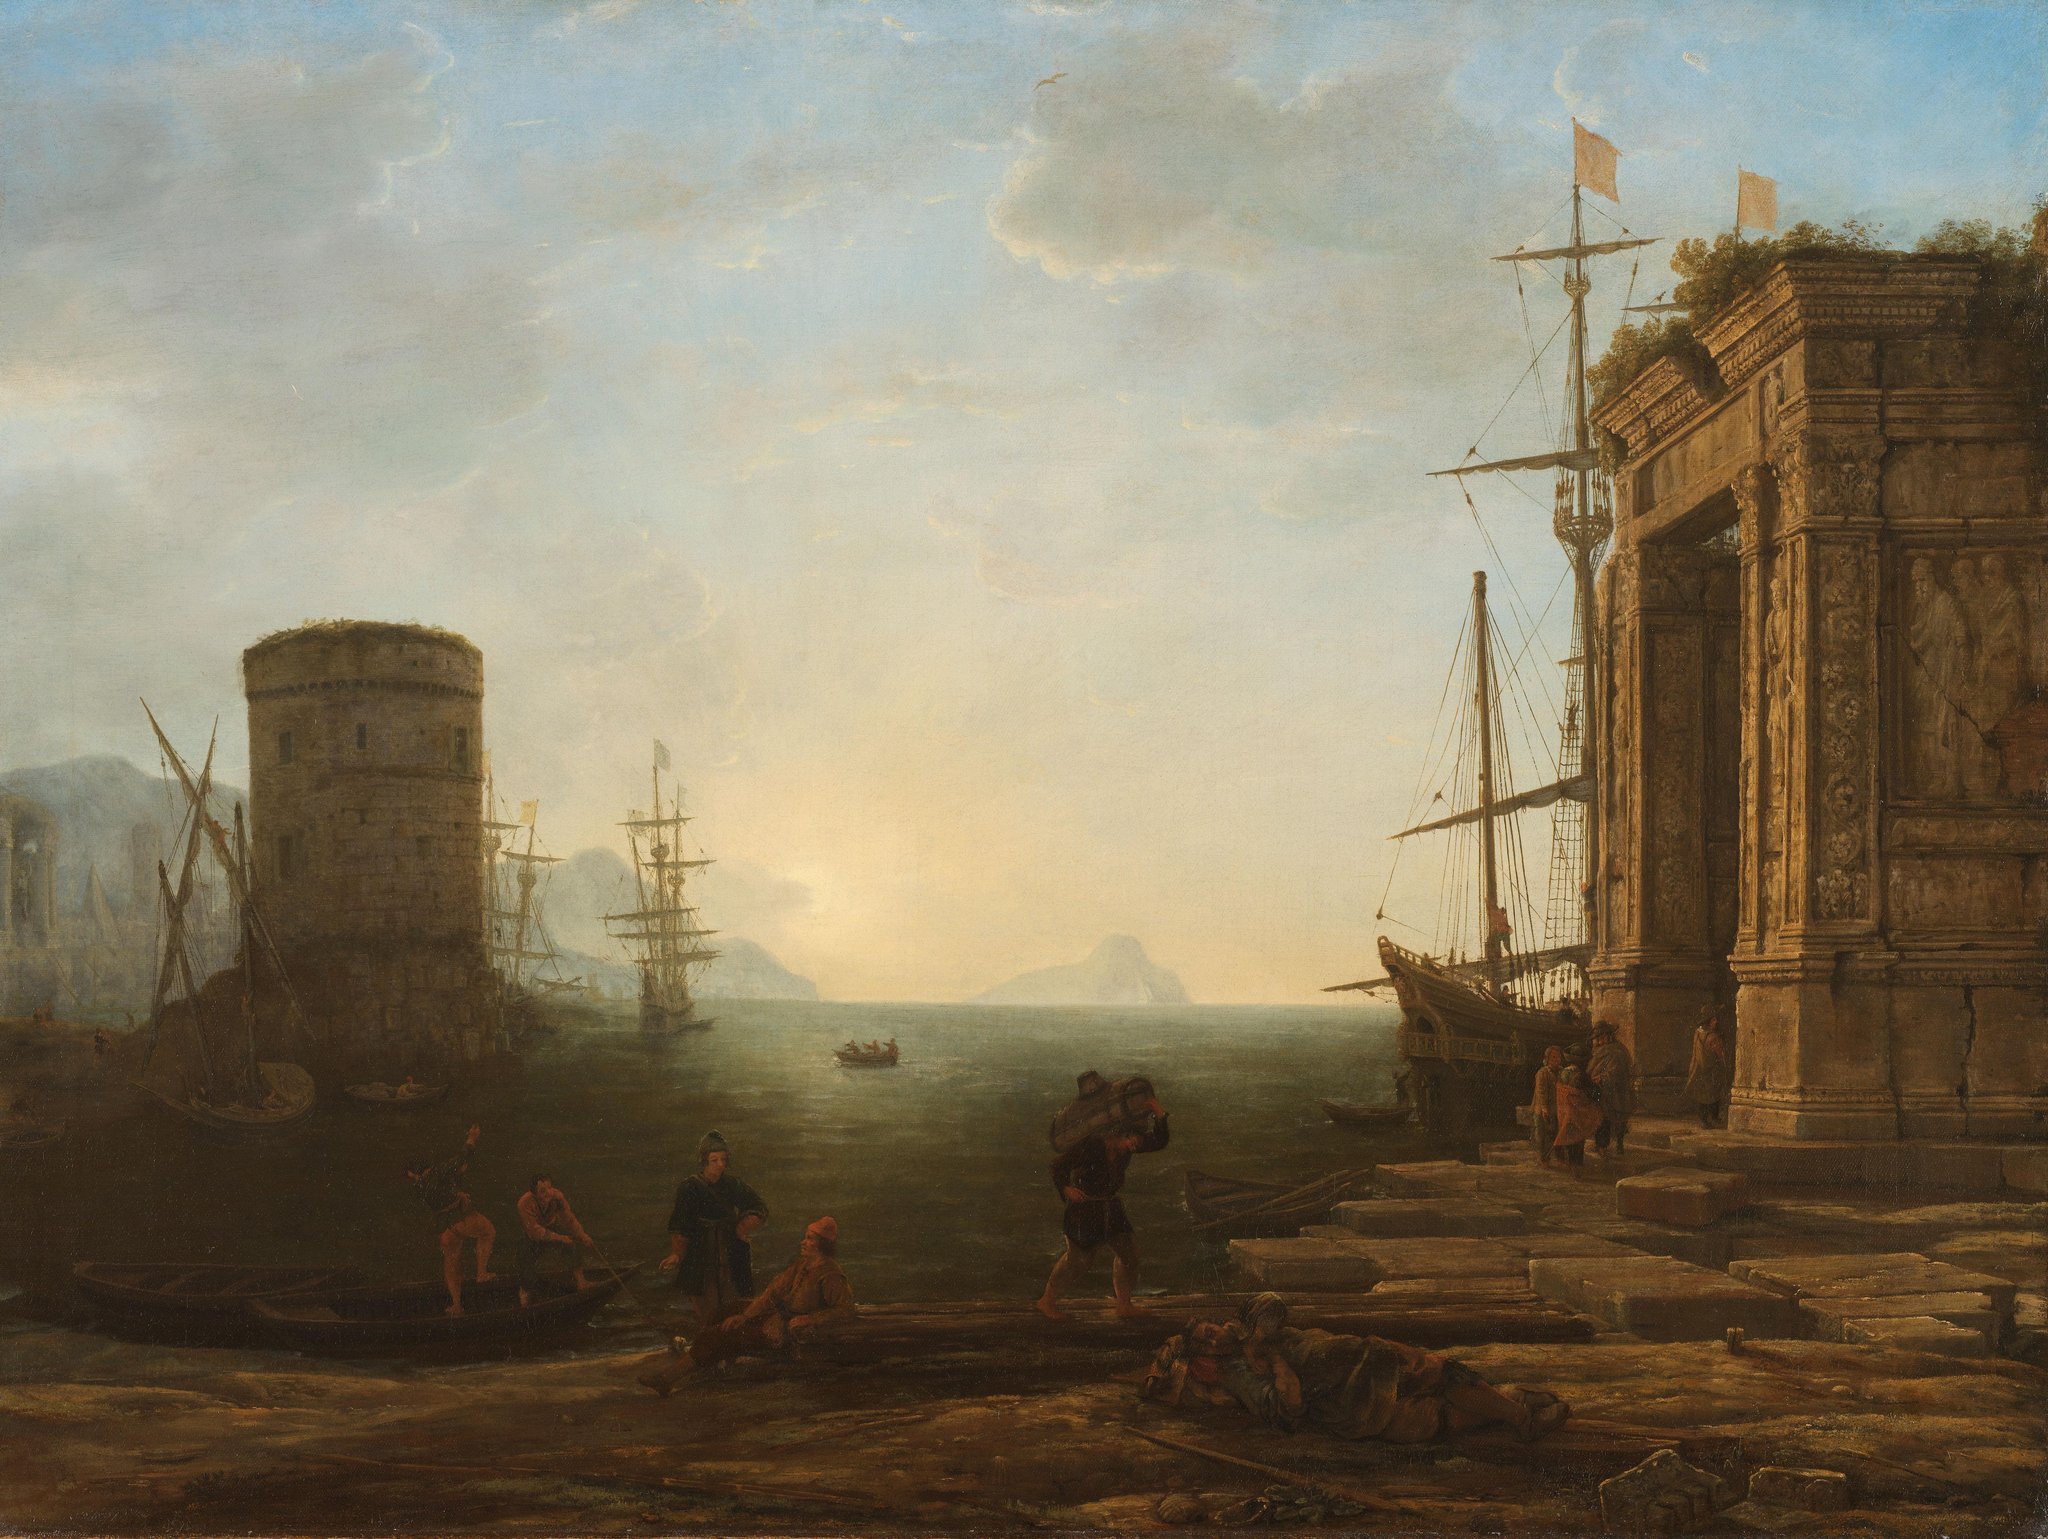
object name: painting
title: Harbour at Sunrise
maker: claude lorrain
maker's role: draughtsman, print maker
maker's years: 1604-1682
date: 1637-1638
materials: canvas, oil, paint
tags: harbour, dawn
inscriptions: signature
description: An imaginary harbour, at the first light of dawn. On the right, a Roman triumphal arch catches the early rays of the sun. Claude Lorrain – a Frenchman who worked in Rome – was a master at capturing the atmosphere of each particular time of day. His poetic, Italianate landscapes influenced many of his contemporaries, including the Dutch Italianates.